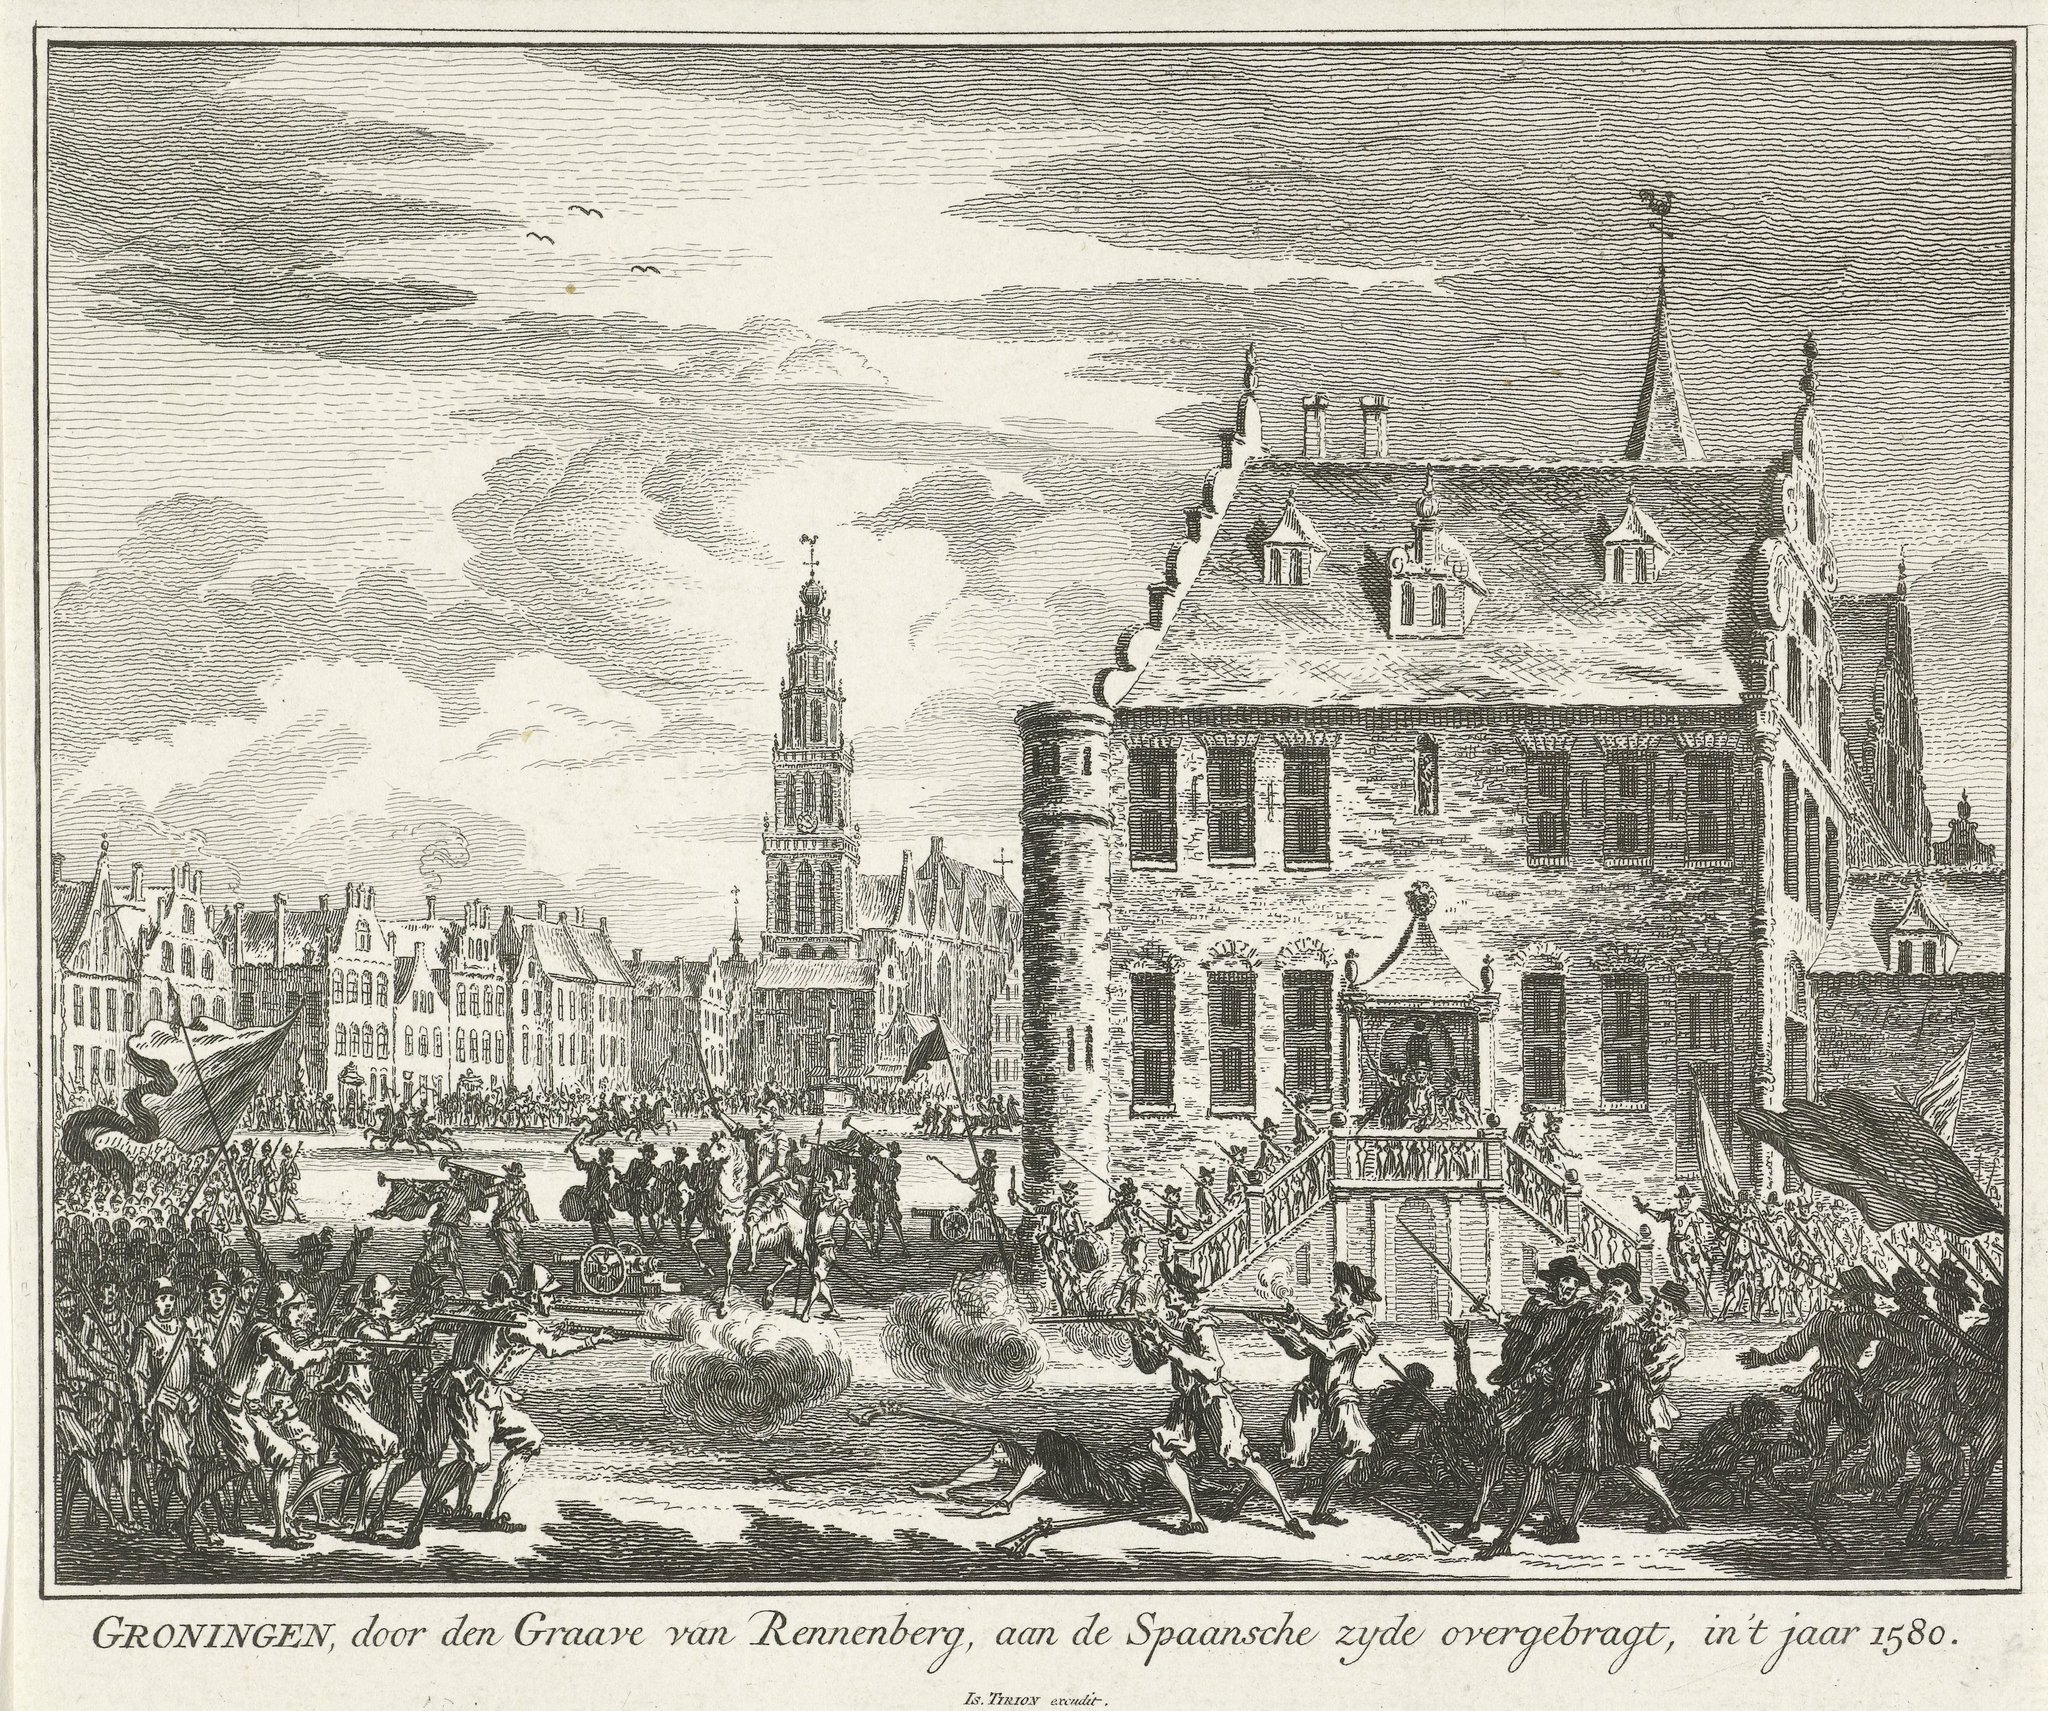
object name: print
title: Groningen veroverd door de troepen van Rennenberg, 1580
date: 1747-1759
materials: paper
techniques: etching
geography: northern netherlands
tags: groningen (province), politician, capture of city (after the siege)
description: Groningen veroverd door de troepen van Rennenberg, 3 maart 1580. Gevechten op de Grote Markt voor het stadhuis.